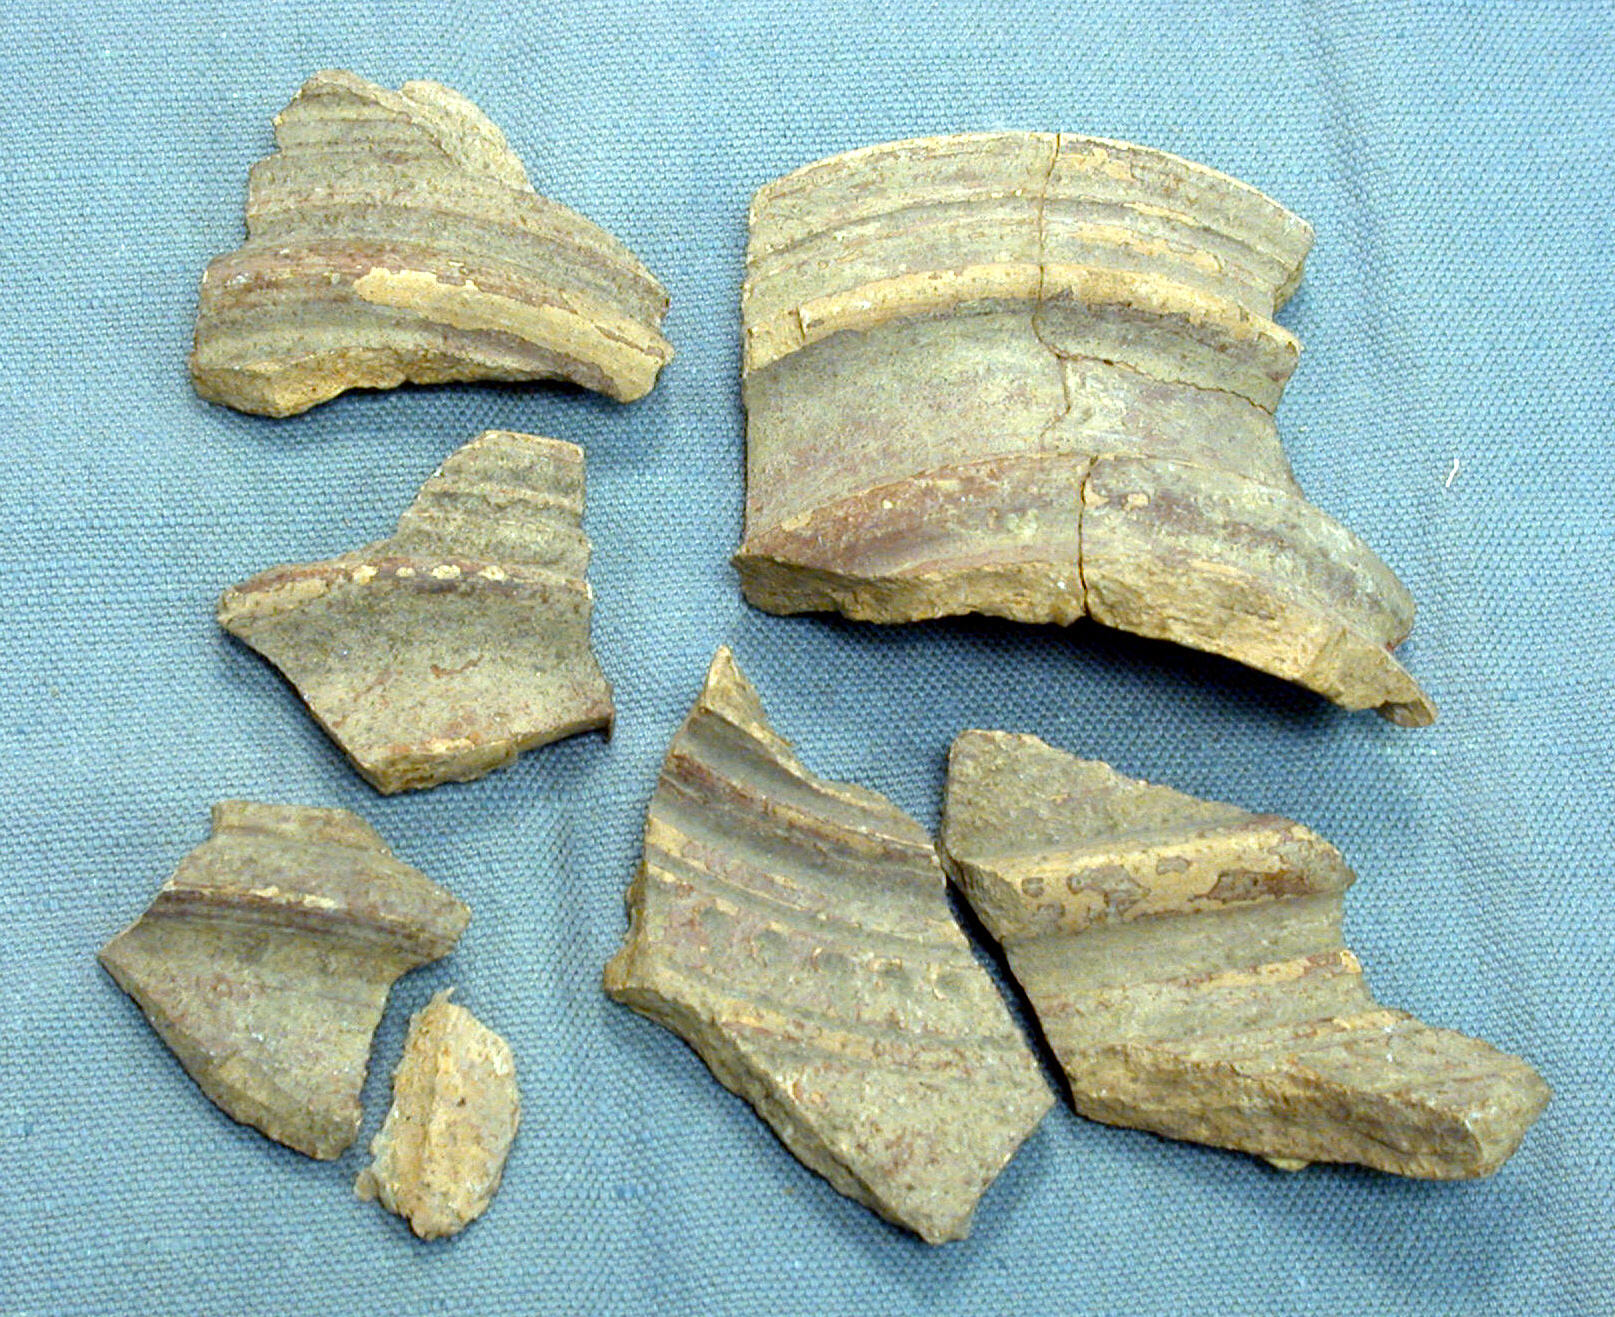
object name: sherd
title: Sherds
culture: sasanian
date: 201-700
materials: ceramic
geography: iran